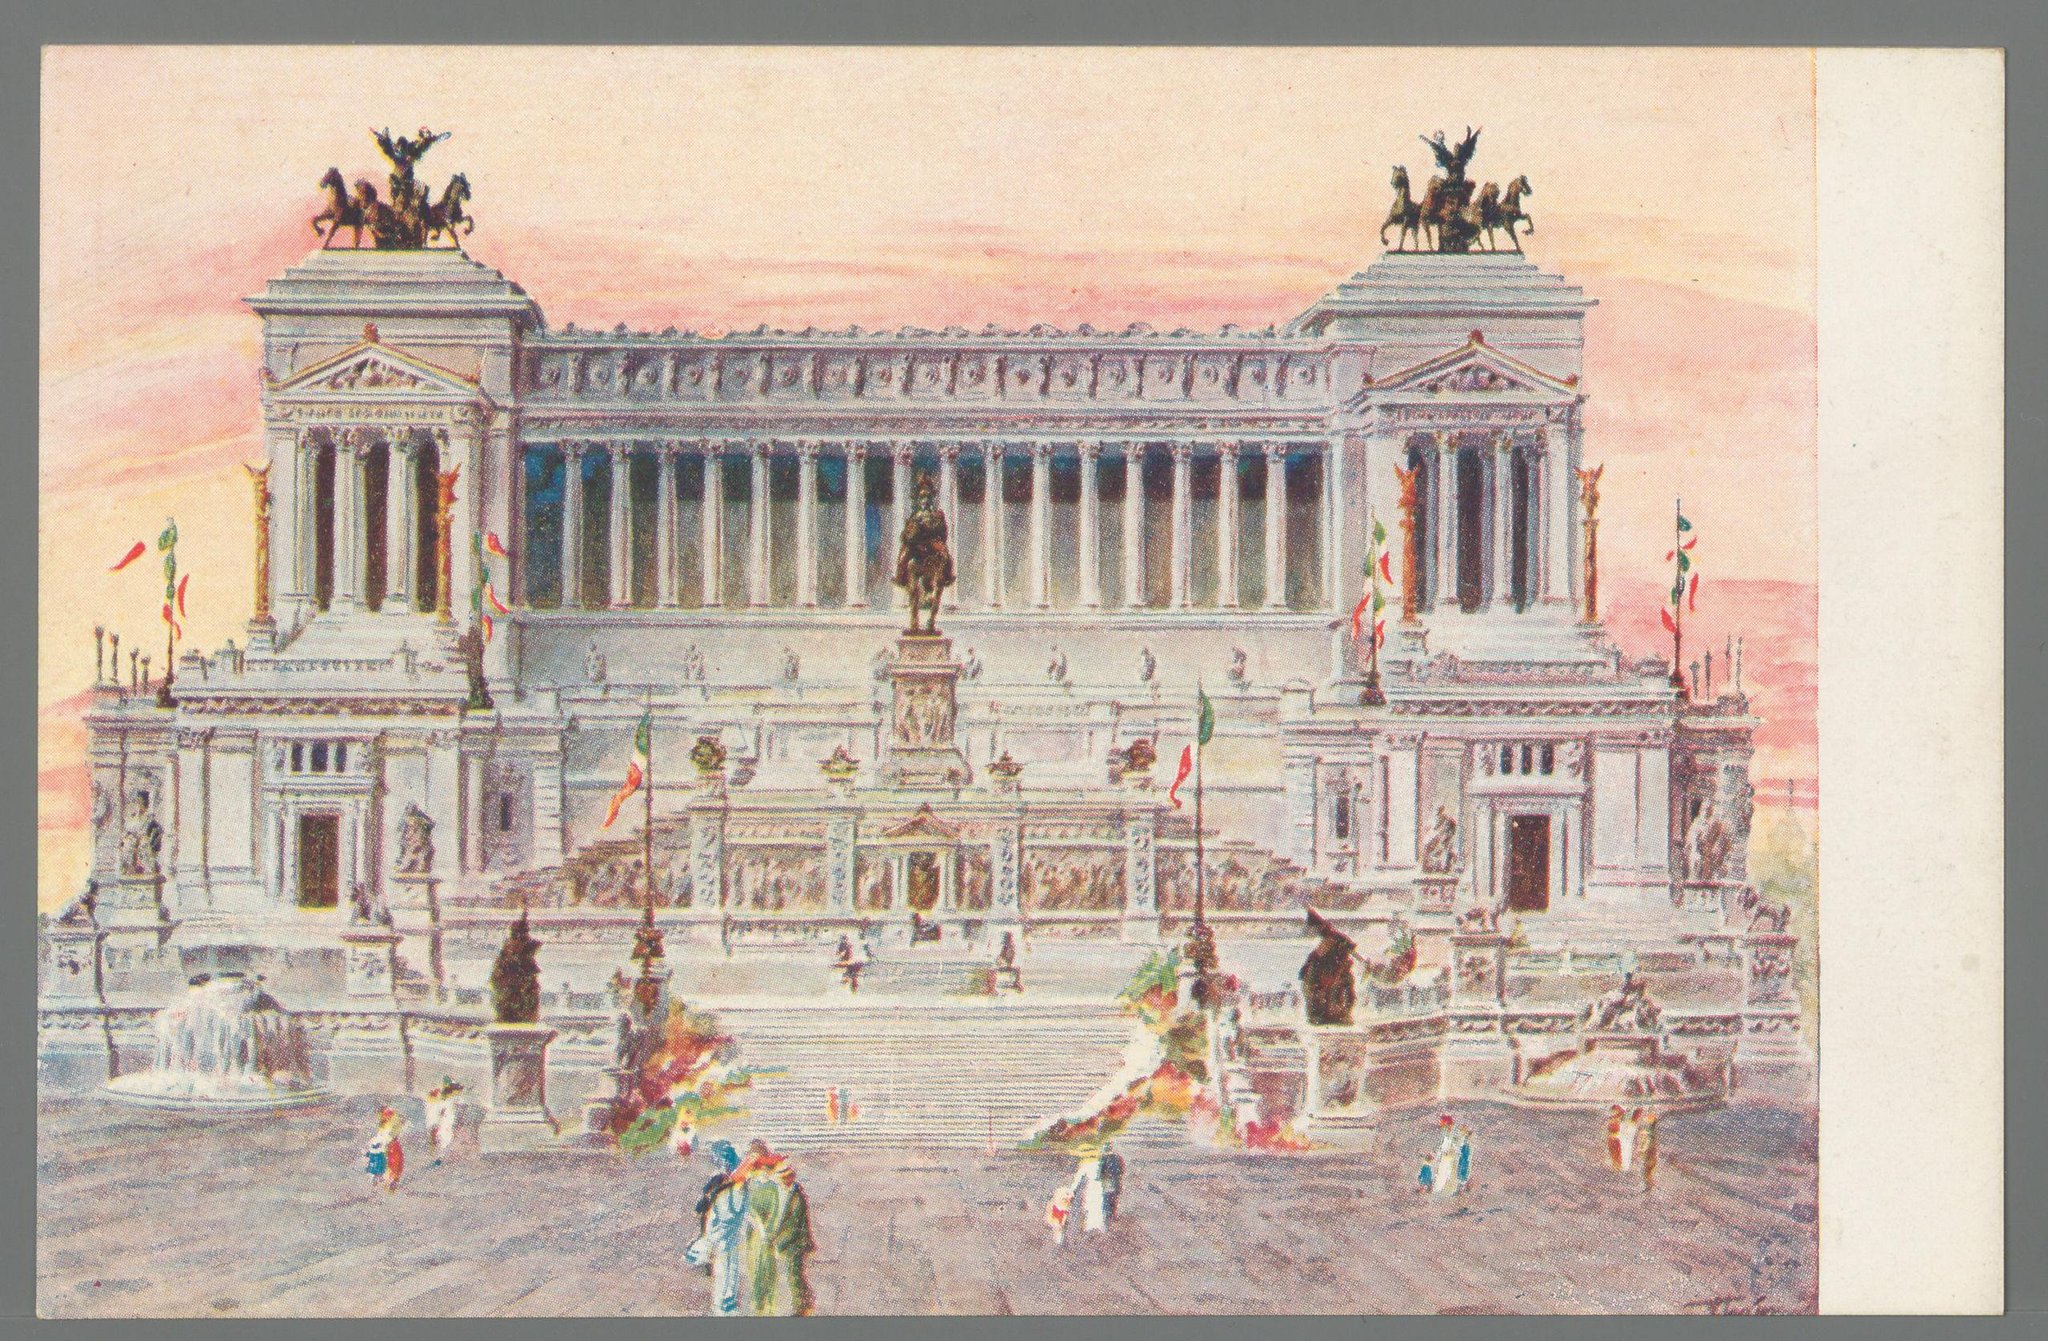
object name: photomechanical print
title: Roma. Monumento a V.E. II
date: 1906-1930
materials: cardboard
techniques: four-color autotype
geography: milan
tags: monument, statue (+ city(-scape) with figures, staffage), square, place, circus, etc. (+ city(-scape) with figures, staffage), rome